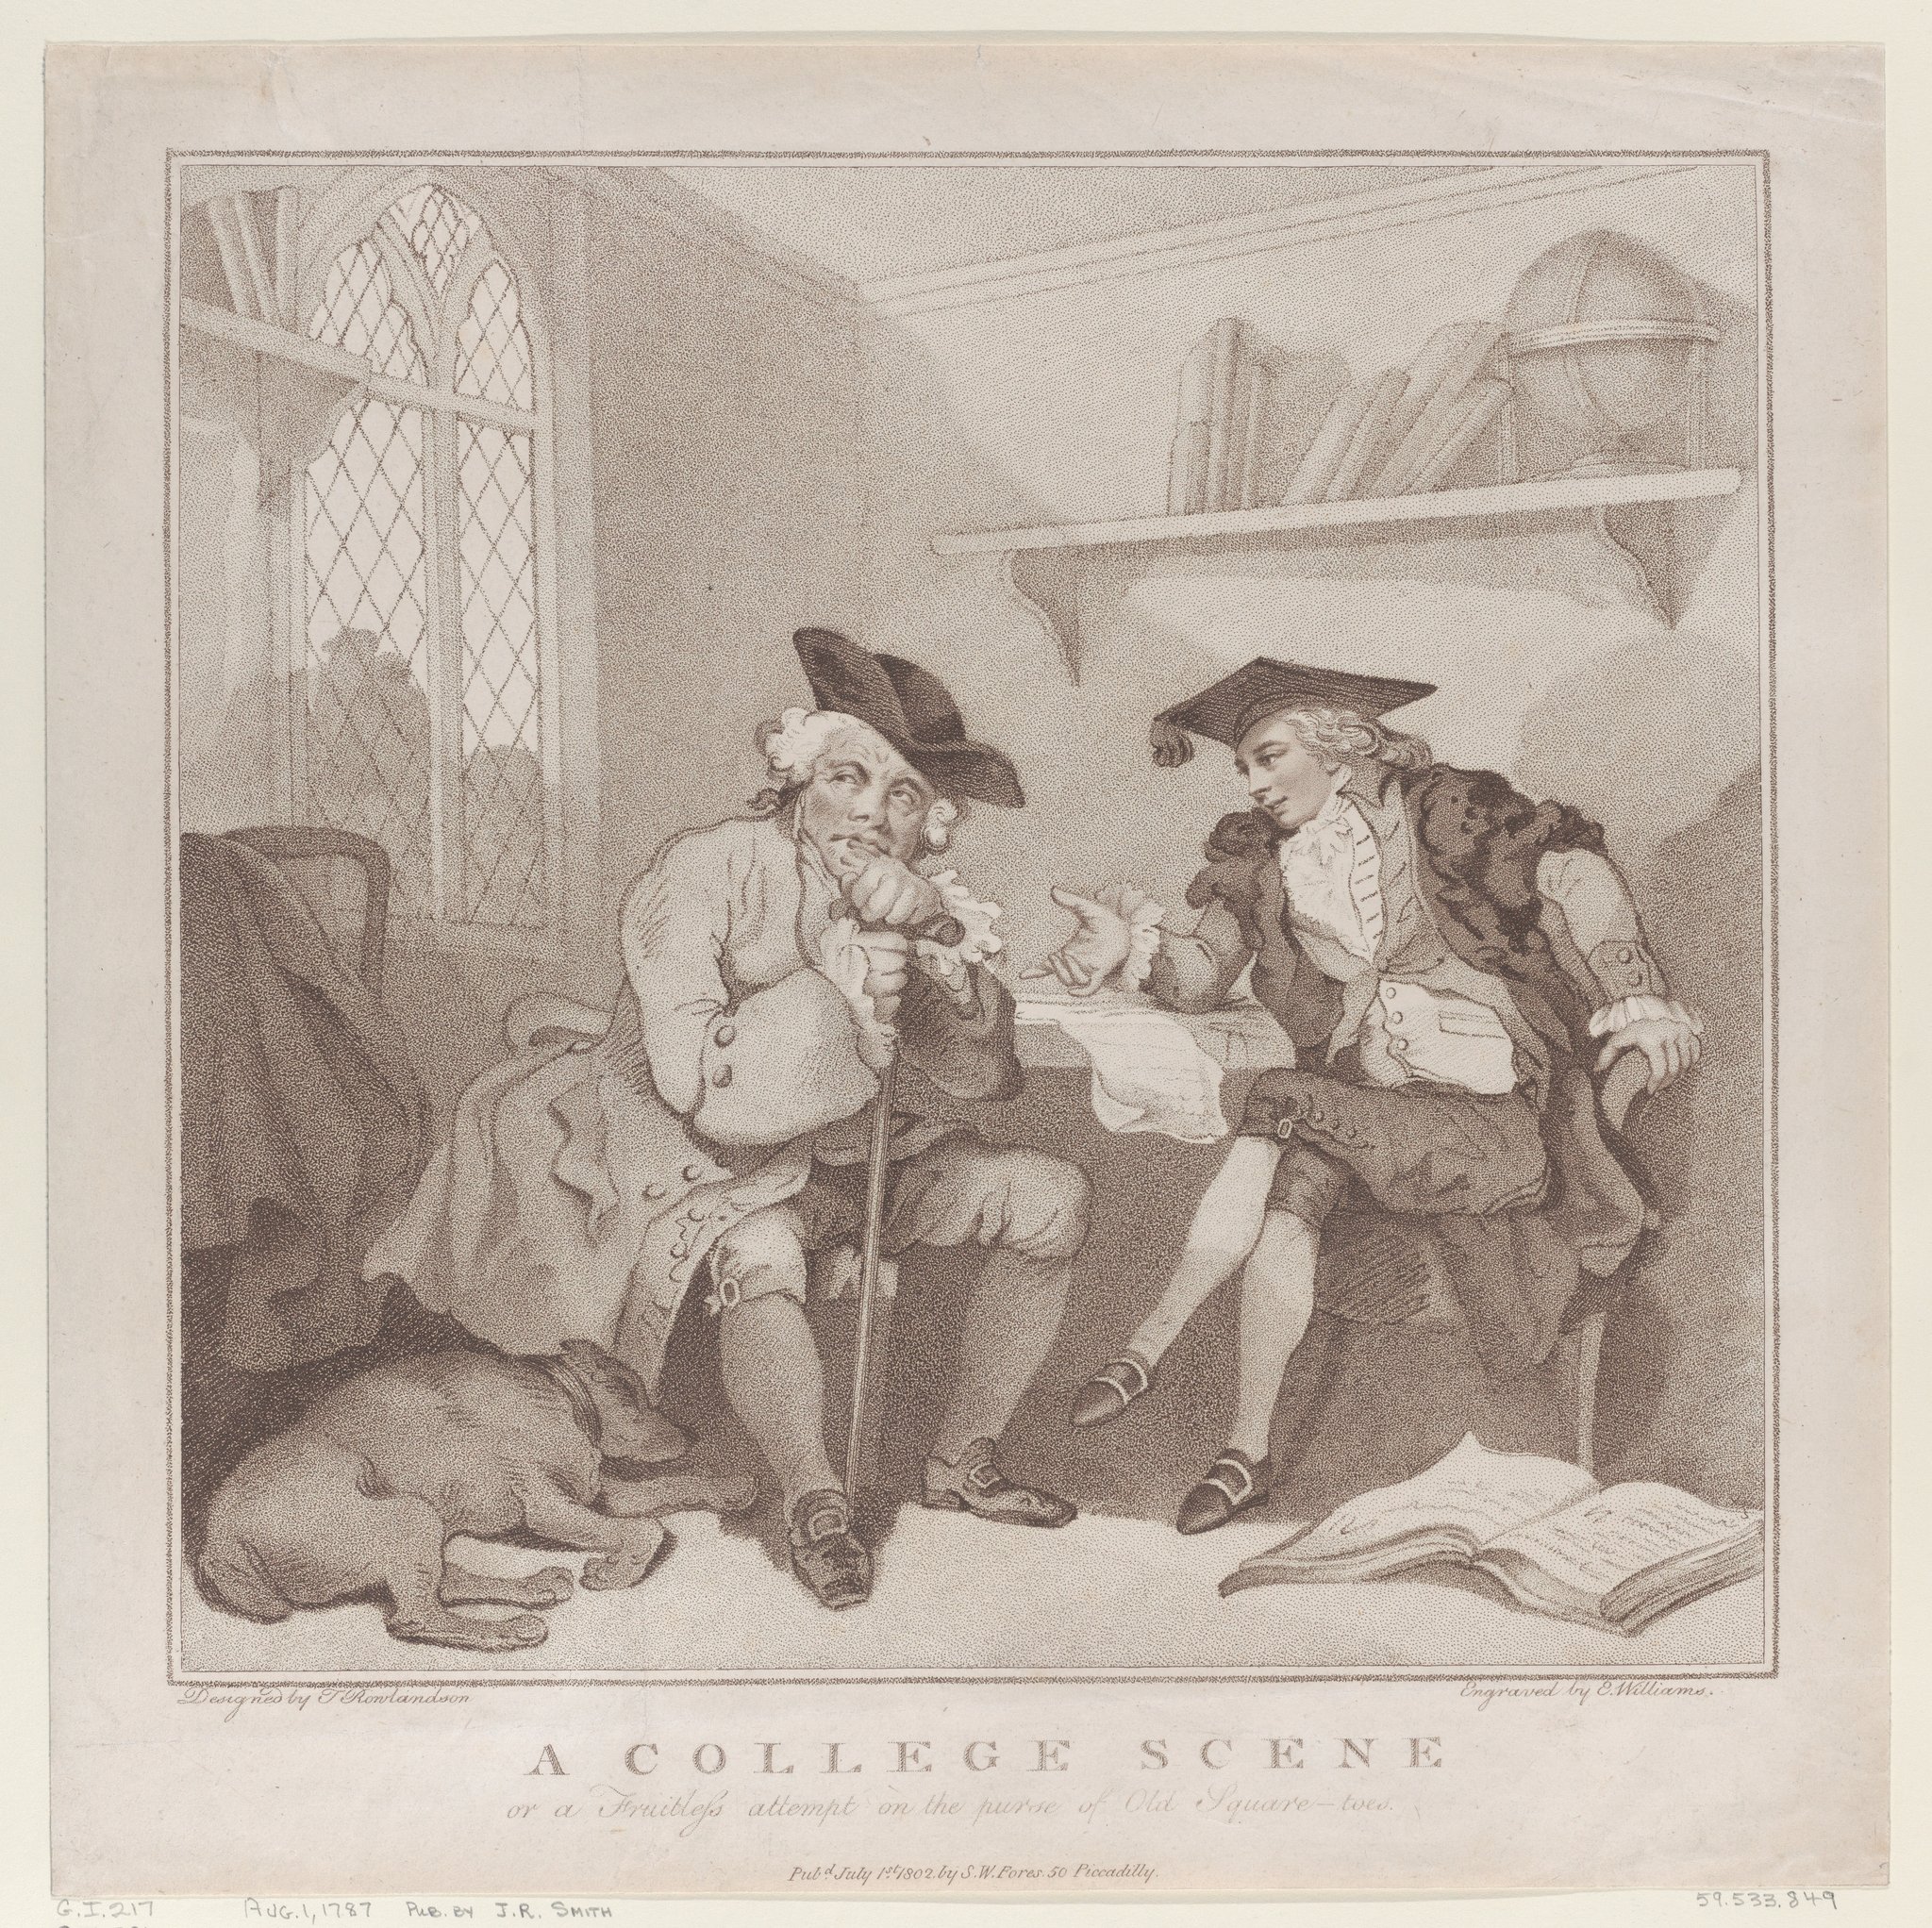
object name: print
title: A College Scene, or a Fruitless Attempt on the Purse of Old Square-toes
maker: edward williams the elder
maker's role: artist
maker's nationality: british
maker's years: 1750-1800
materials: ink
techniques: etching, printing, stippling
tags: men,dogs